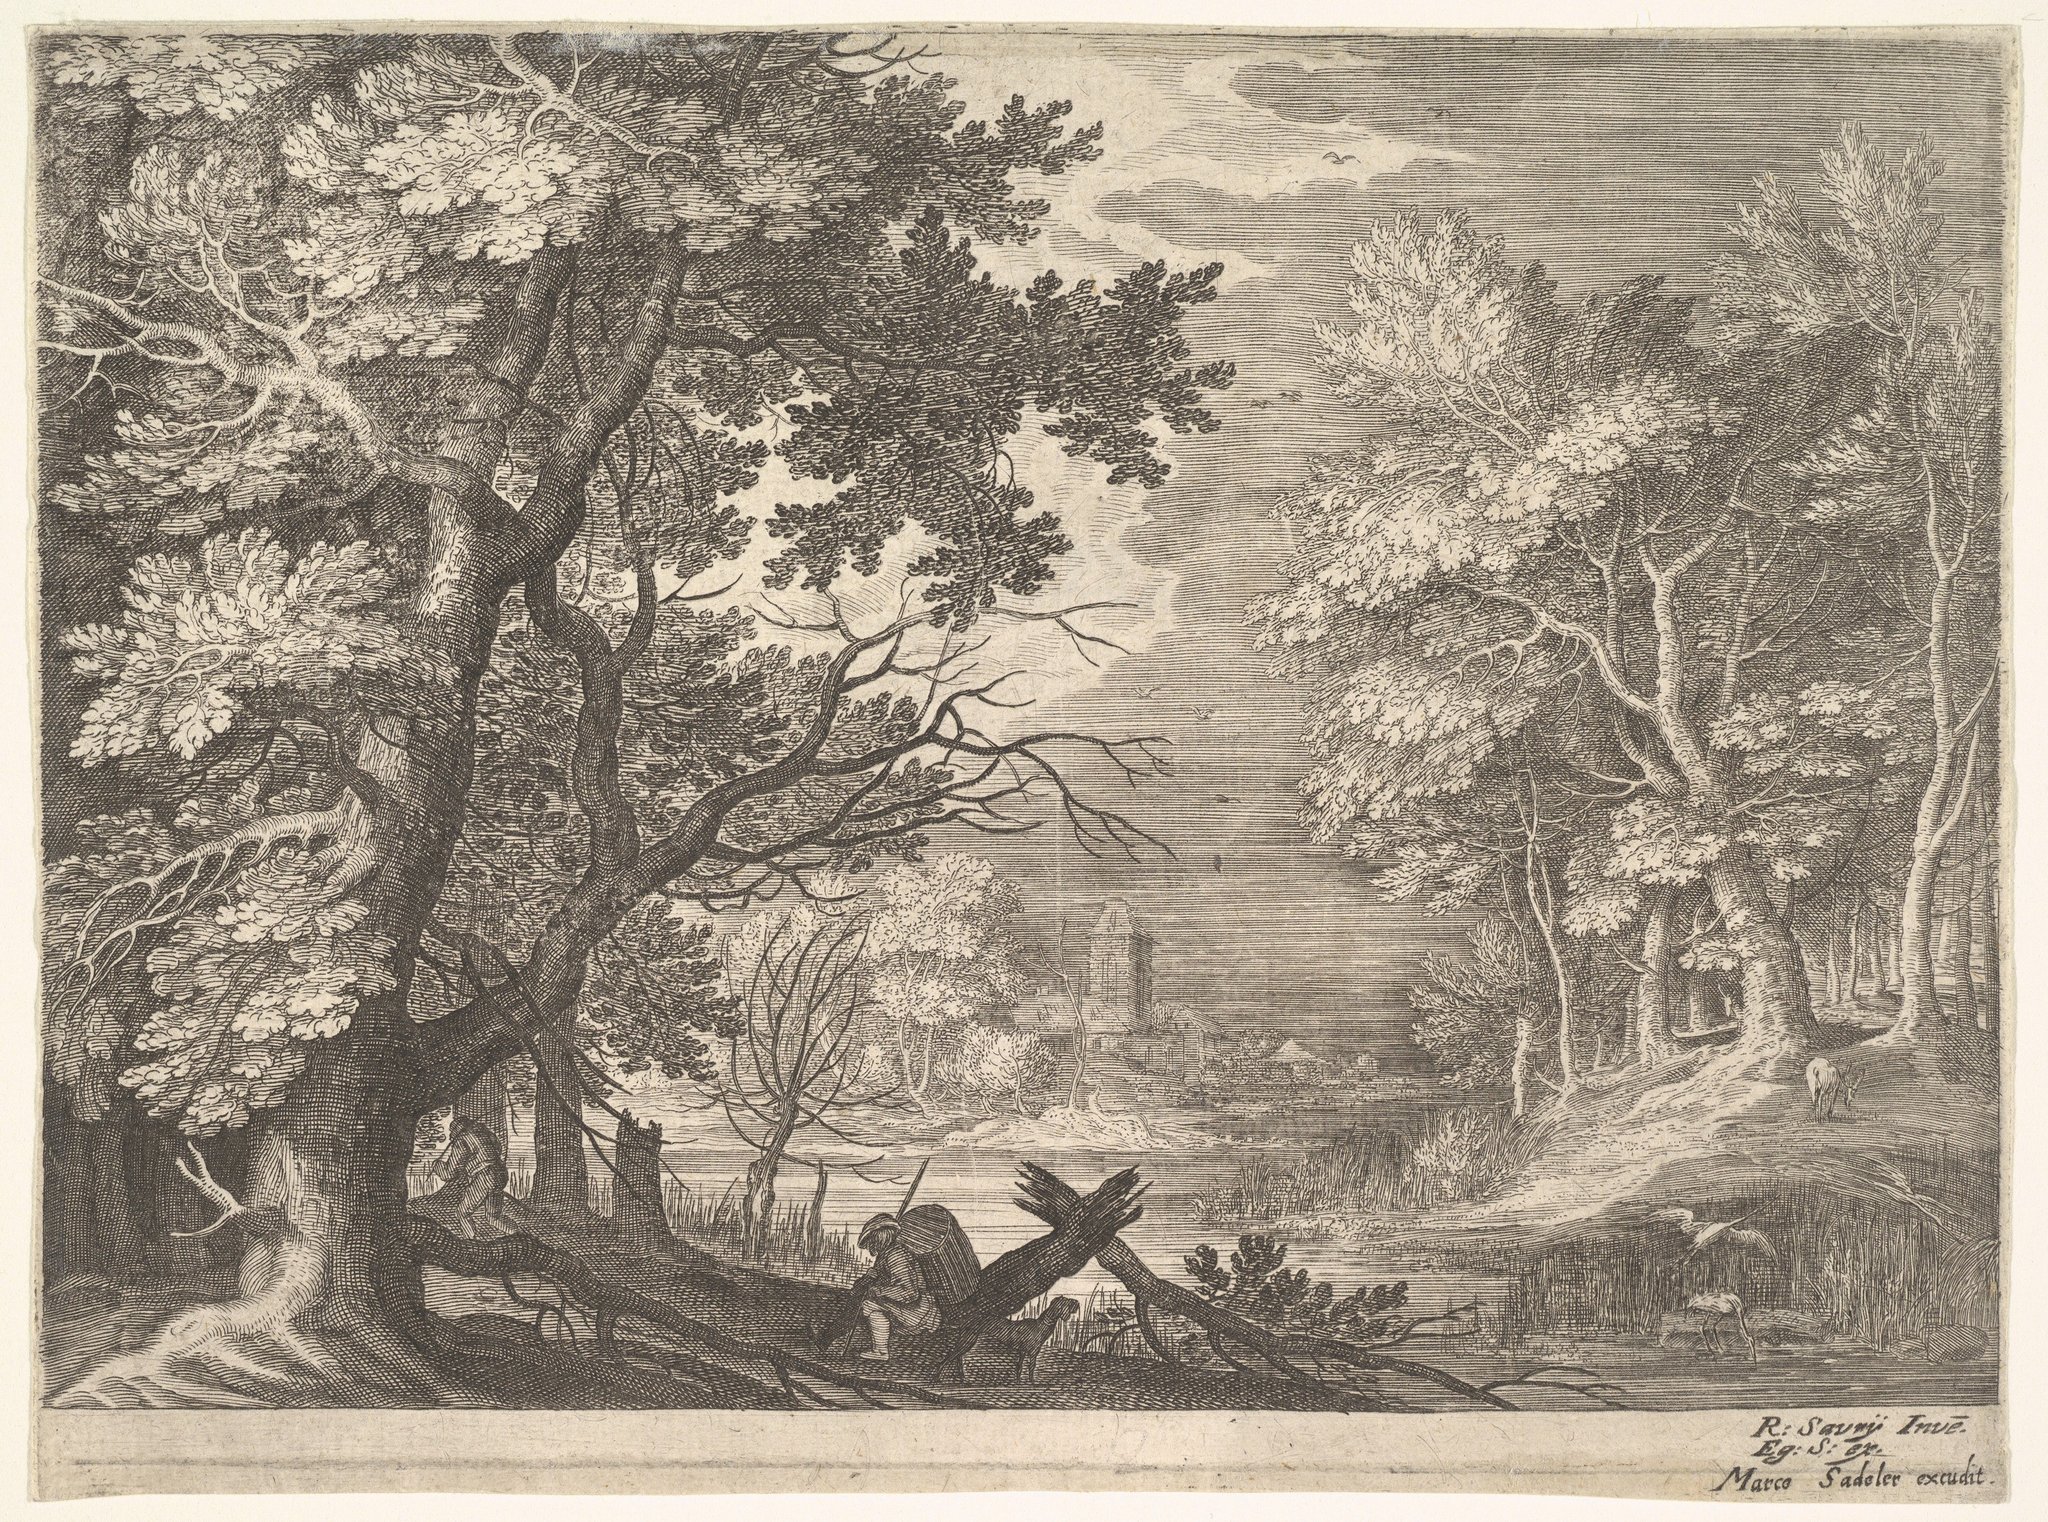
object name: print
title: Woodland scene with marshy banks, from "Six Landscapes in Tyrol"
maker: roelandt savery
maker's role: artist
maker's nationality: flemish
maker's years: 1576-1639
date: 1600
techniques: engraving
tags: birds,men,dogs,landscapes,trees